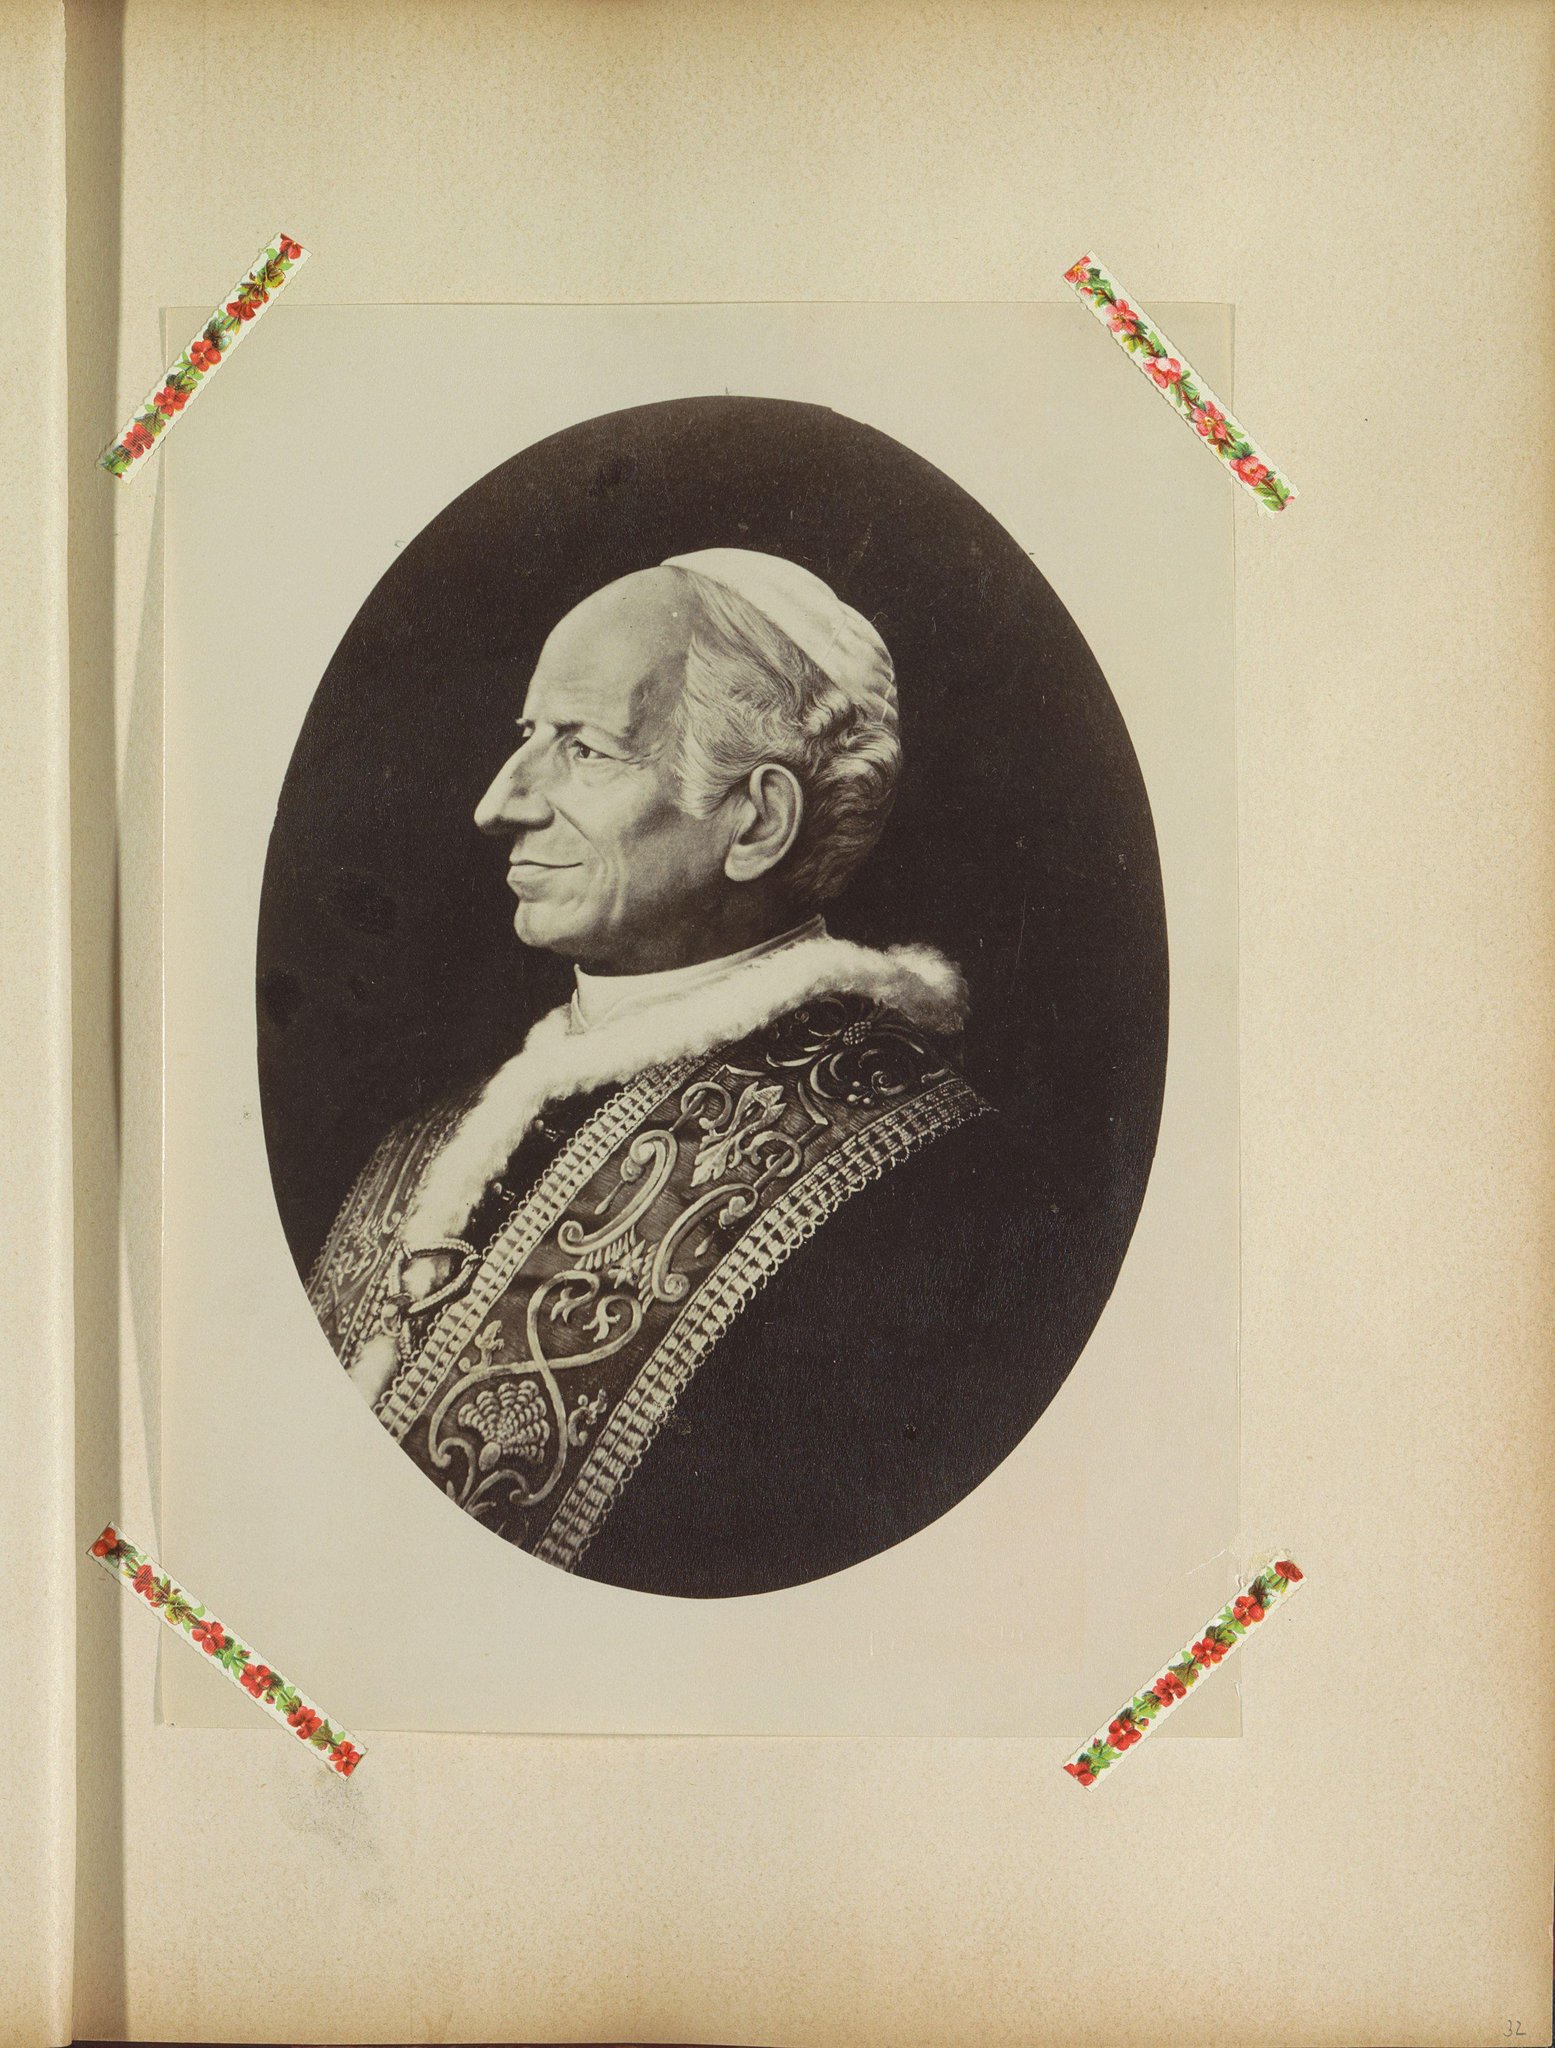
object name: reproduction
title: Fotoreproductie van een (mogelijk) geschilderd portret van paus Leo XIII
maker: Anonymous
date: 1878-1900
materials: photographic support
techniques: albumen print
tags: leo xiii, pope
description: Onderdeel van Fotoalbum met opnames van bezienswaardigheden in Italiaanse steden en van kunstwerken.